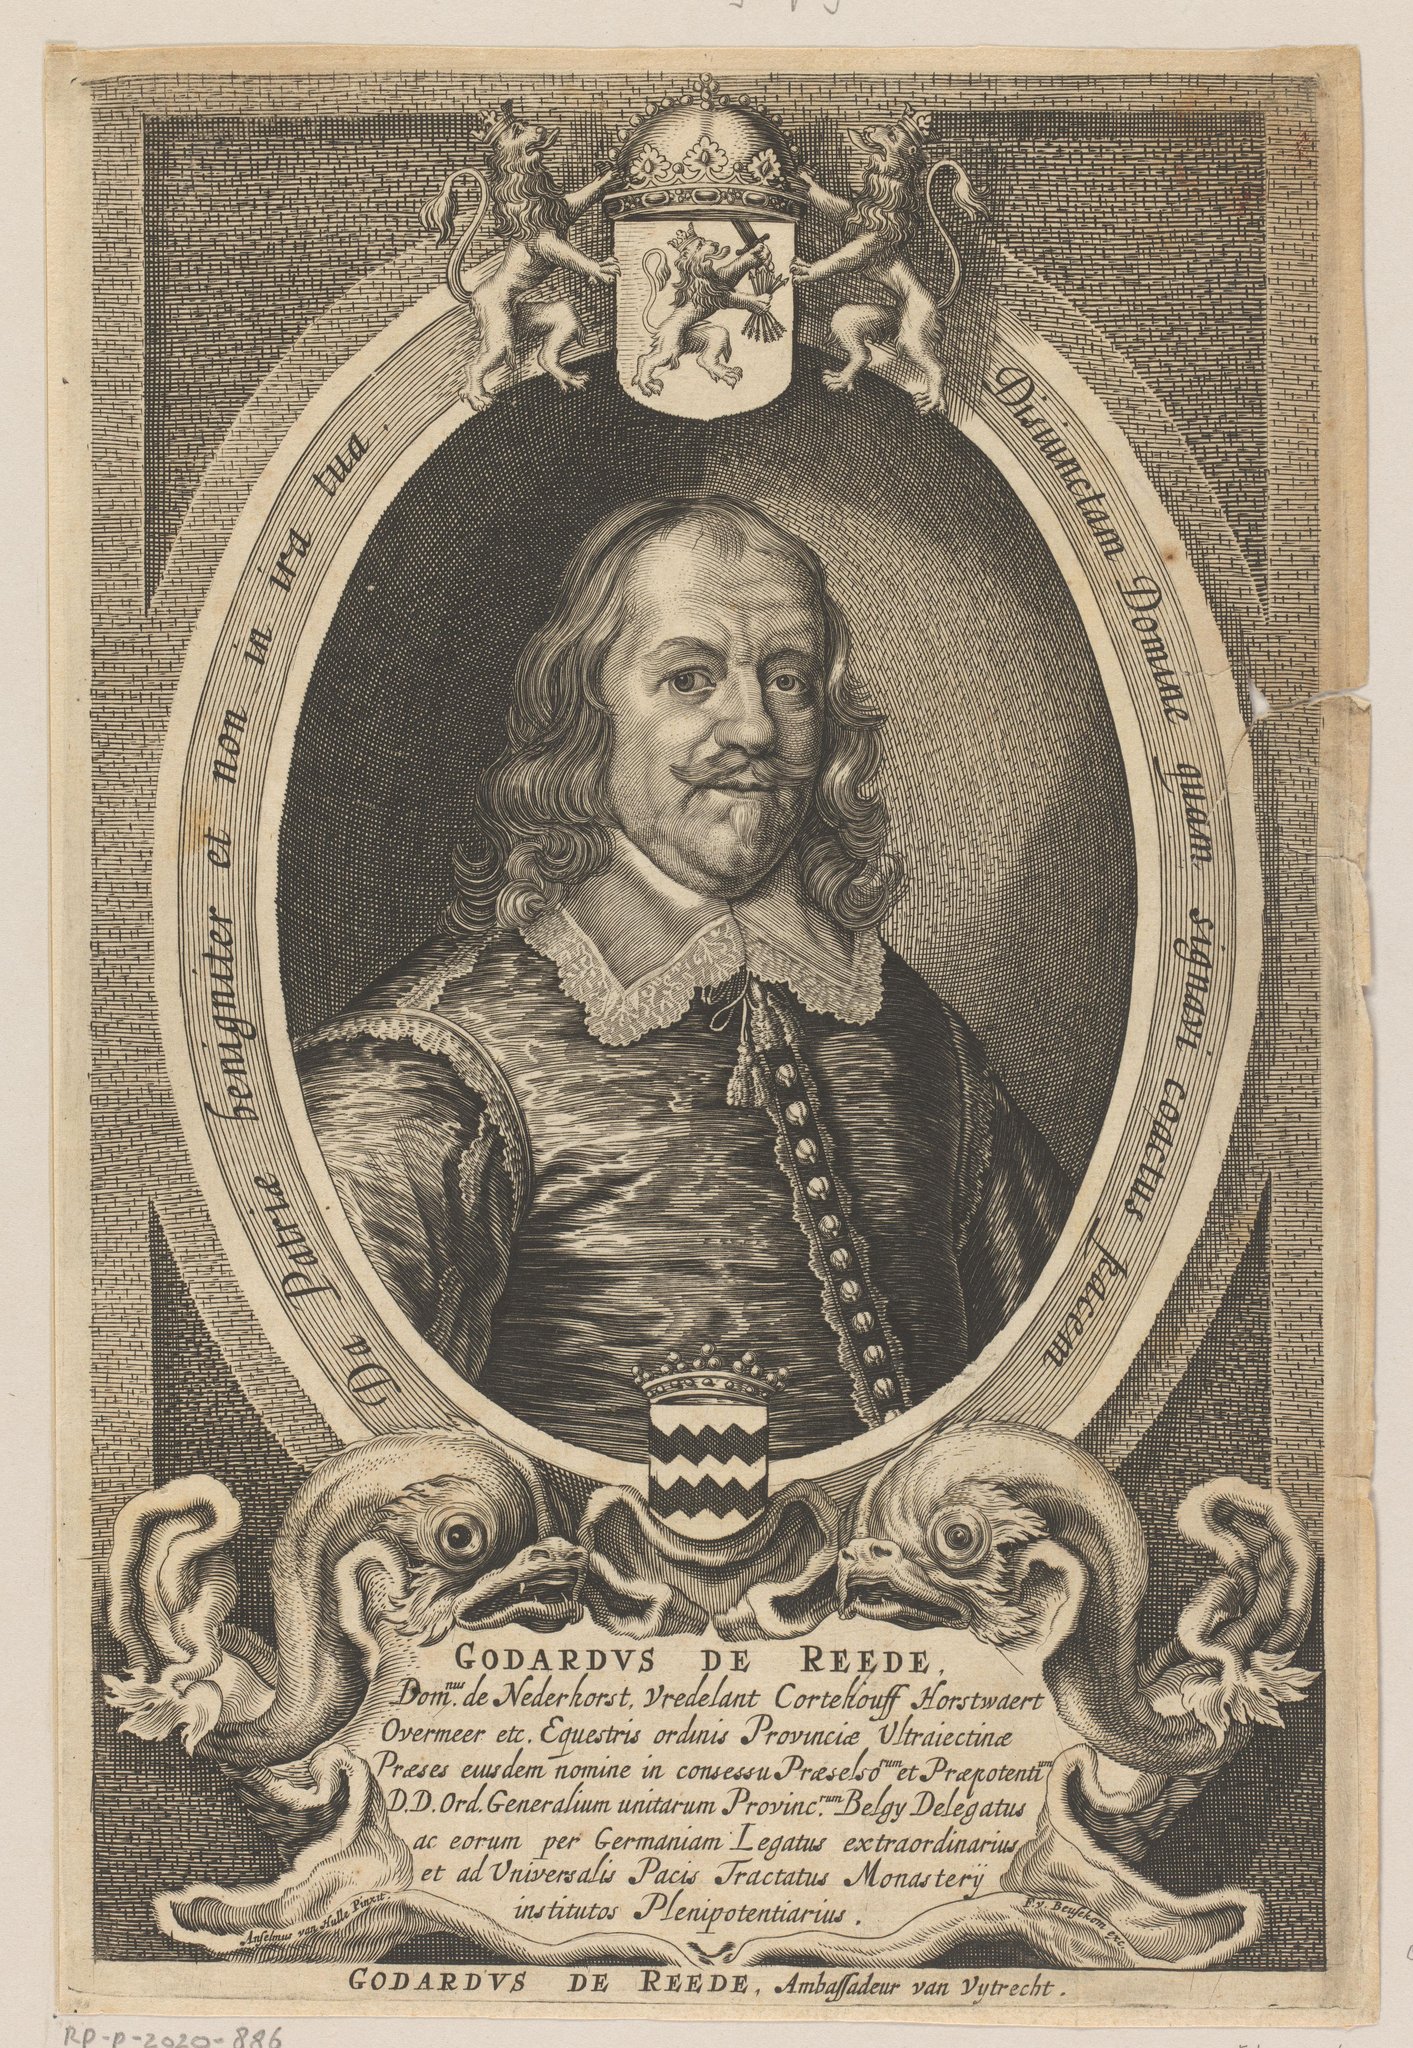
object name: print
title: Godardus de Reede. Dominus de Nederhorst, Vredelant, Cortehouff, Horstwaert, Overmeer etc. (...)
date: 1648-1665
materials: paper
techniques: engraving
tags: utrecht, historical persons, nobility and patriciate; chivalry, knighthood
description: Spiegelbeeldige kopie naar een prent van Cornelis Galle II. Zie documentatie. De prent maakt waarschijnlijk onderdeel uit van een serie portretten met vredesonderhandelaars die betrokken waren bij de Vrede van Münster.